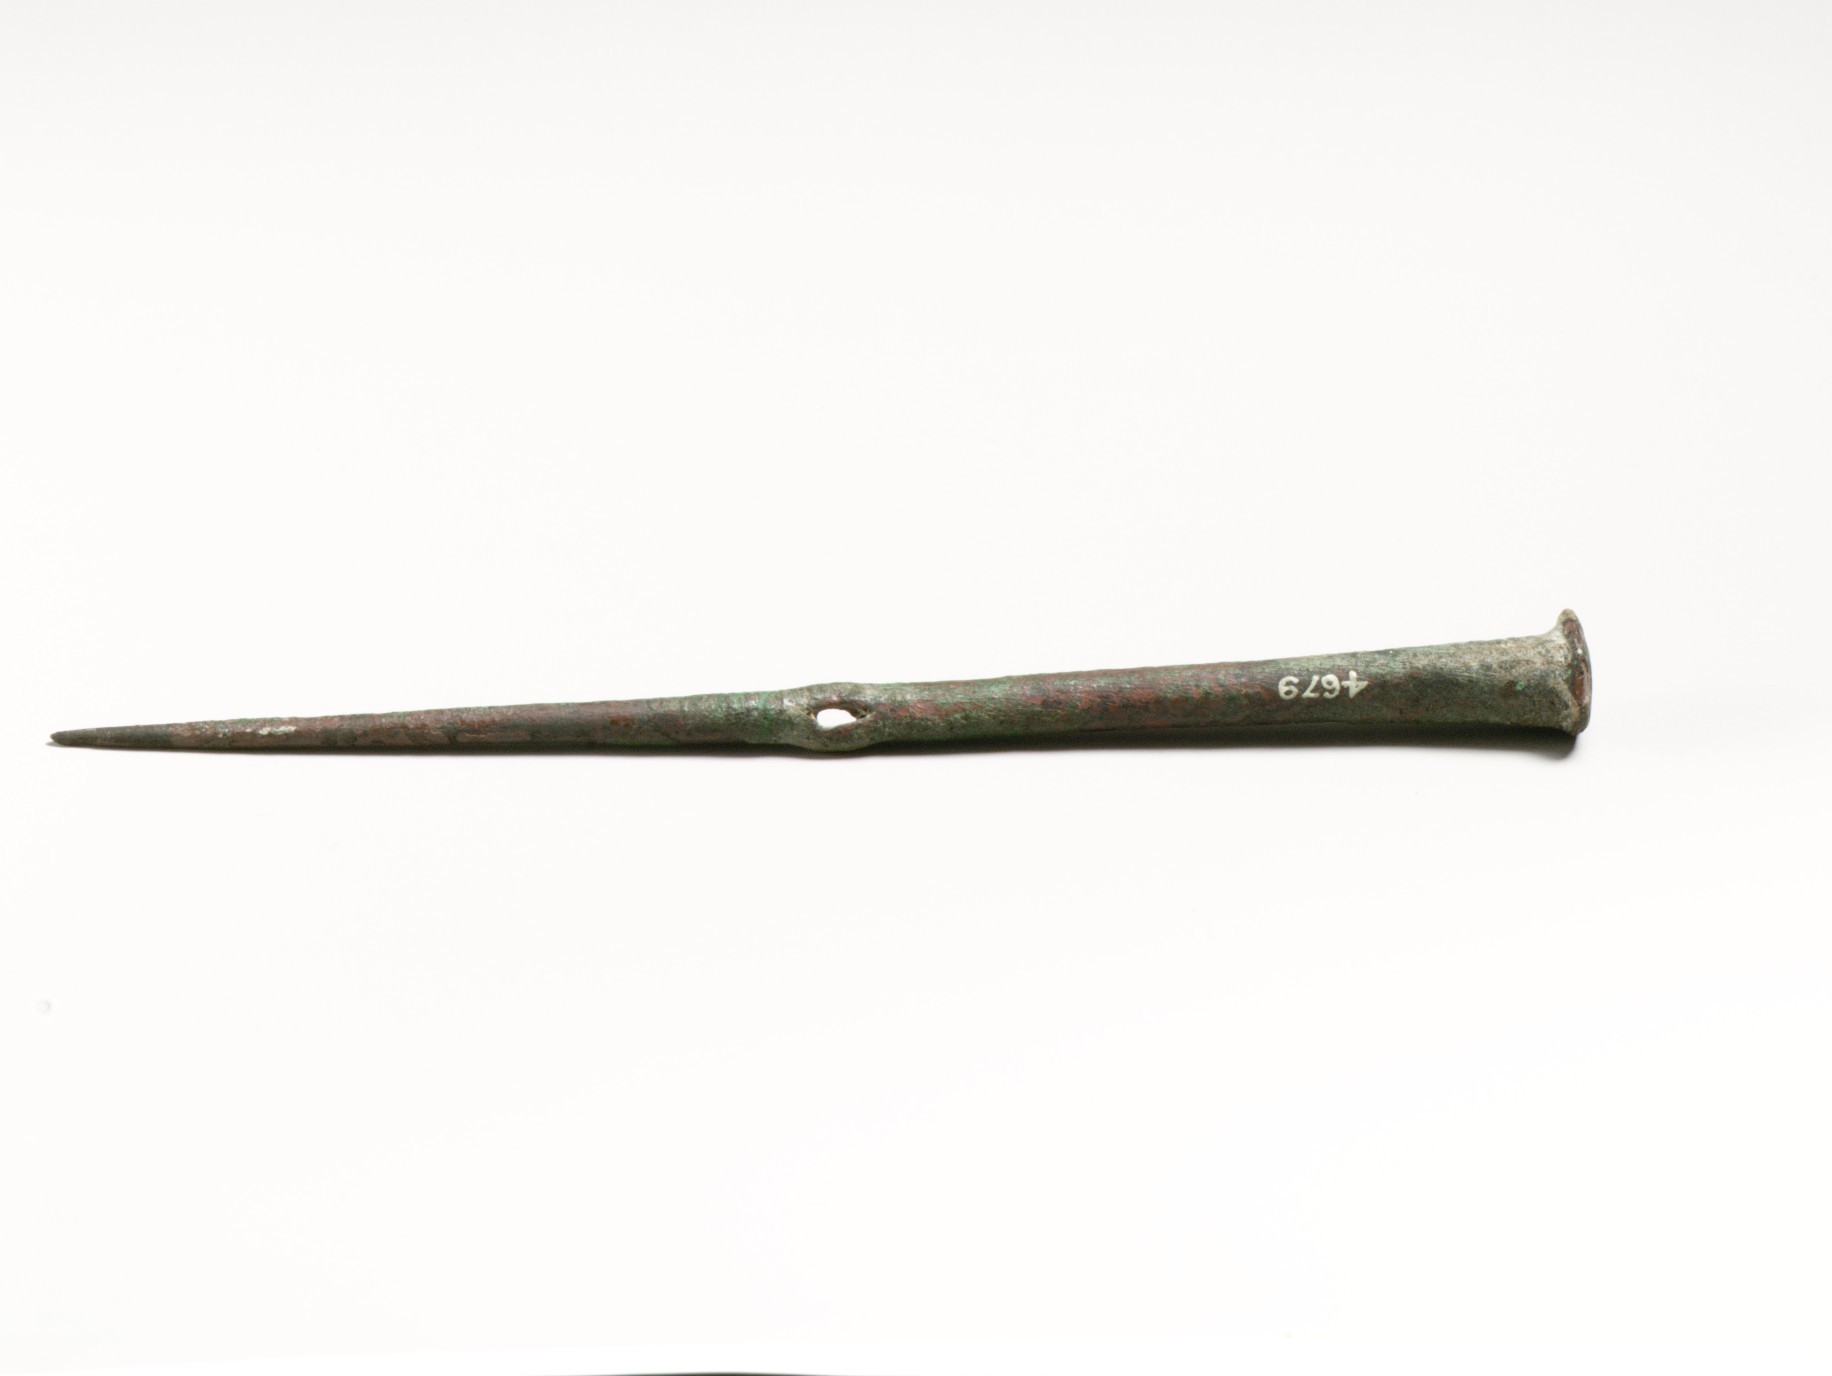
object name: pin, eyelet type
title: Bronze eyelet-type pin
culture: mycenaean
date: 1400-1301 BCE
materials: bronze